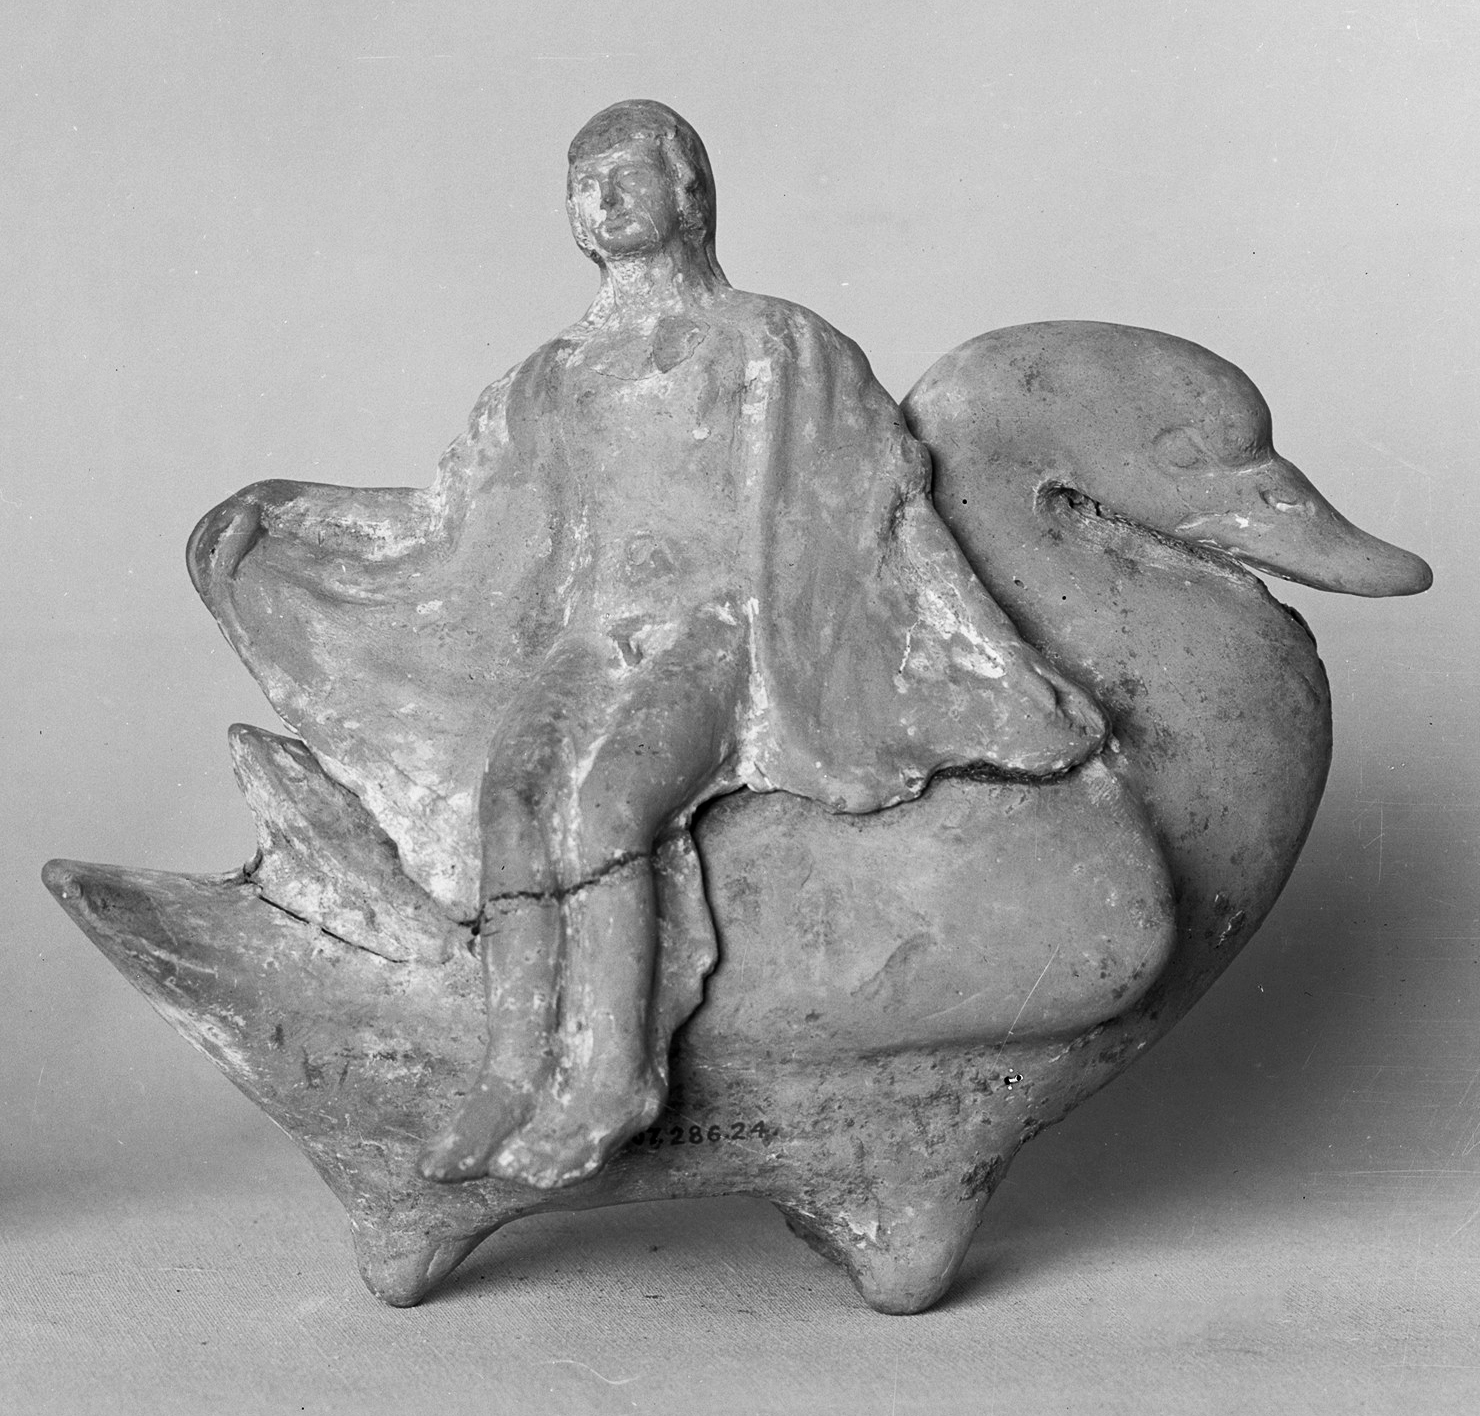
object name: statuette of hyakinthos on a water bird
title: Terracotta statuette of Hyakinthos on a swan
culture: greek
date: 500-401 BCE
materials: terracotta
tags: men,swans